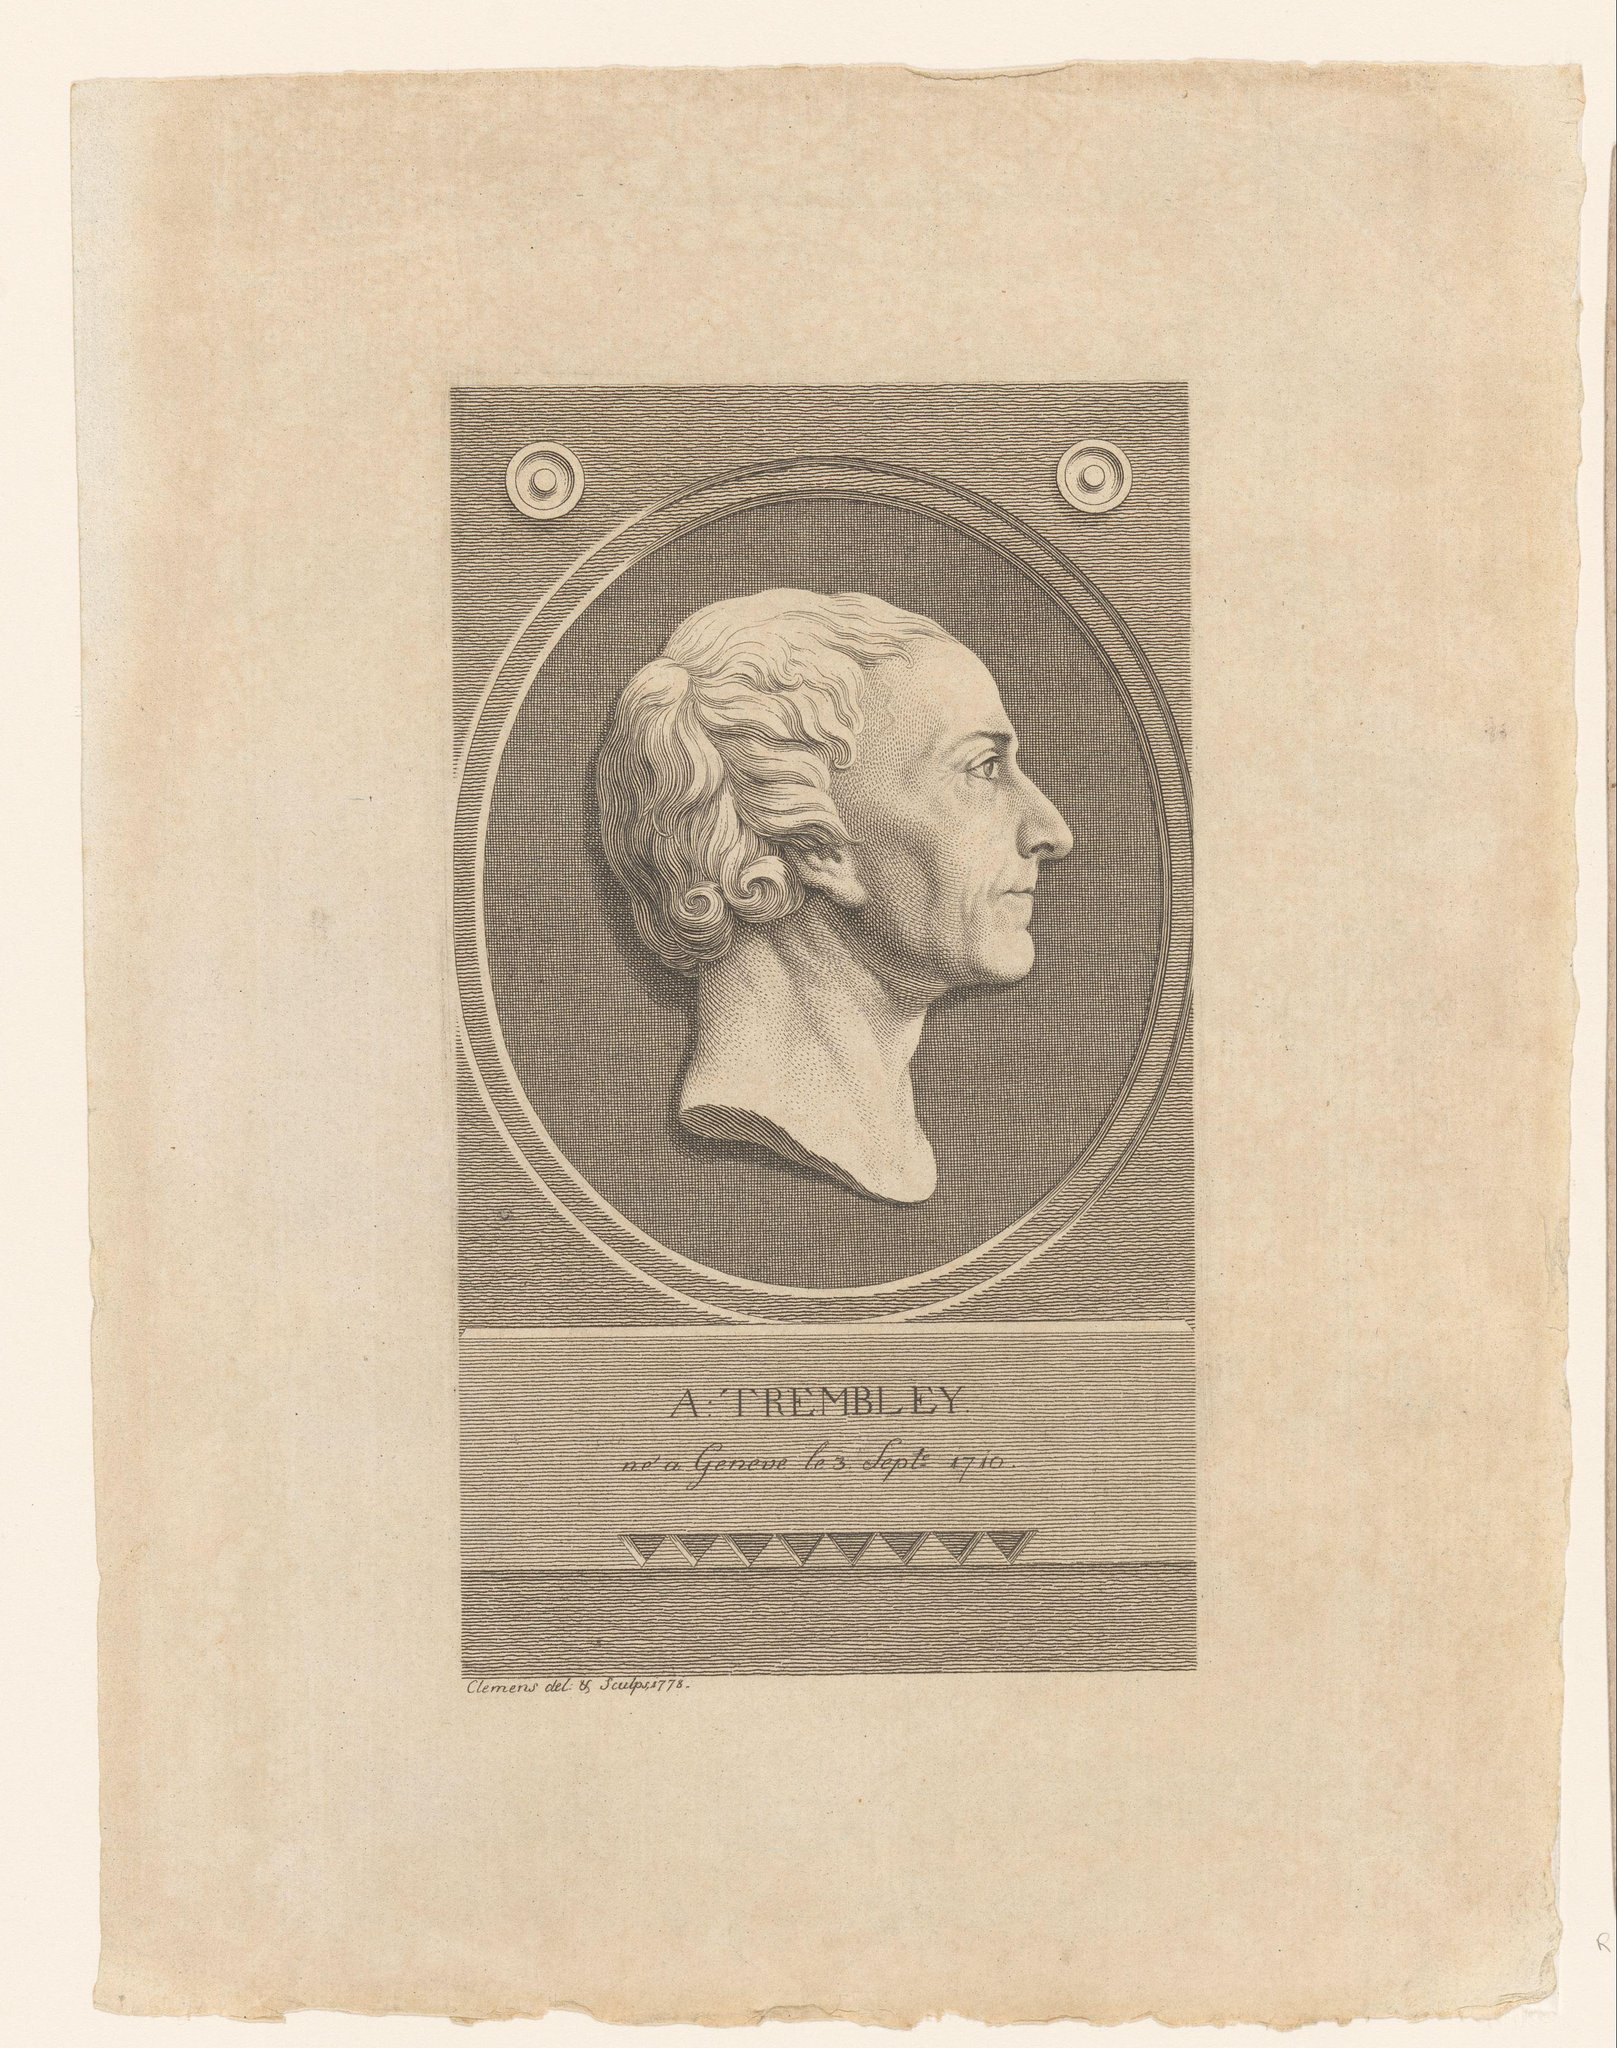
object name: print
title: Portret van Abraham Trembley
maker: johan frederik clemens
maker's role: draughtsman, print maker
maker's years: 1748-1831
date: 1778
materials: paper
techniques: engraving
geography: denmark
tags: physicist, historical persons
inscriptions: collector's mark: Lugt 2228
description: Portret van Abraham Trembley, Zwitsers natuurwetenschapper, hoofd en profil naar rechts, in medaillon.